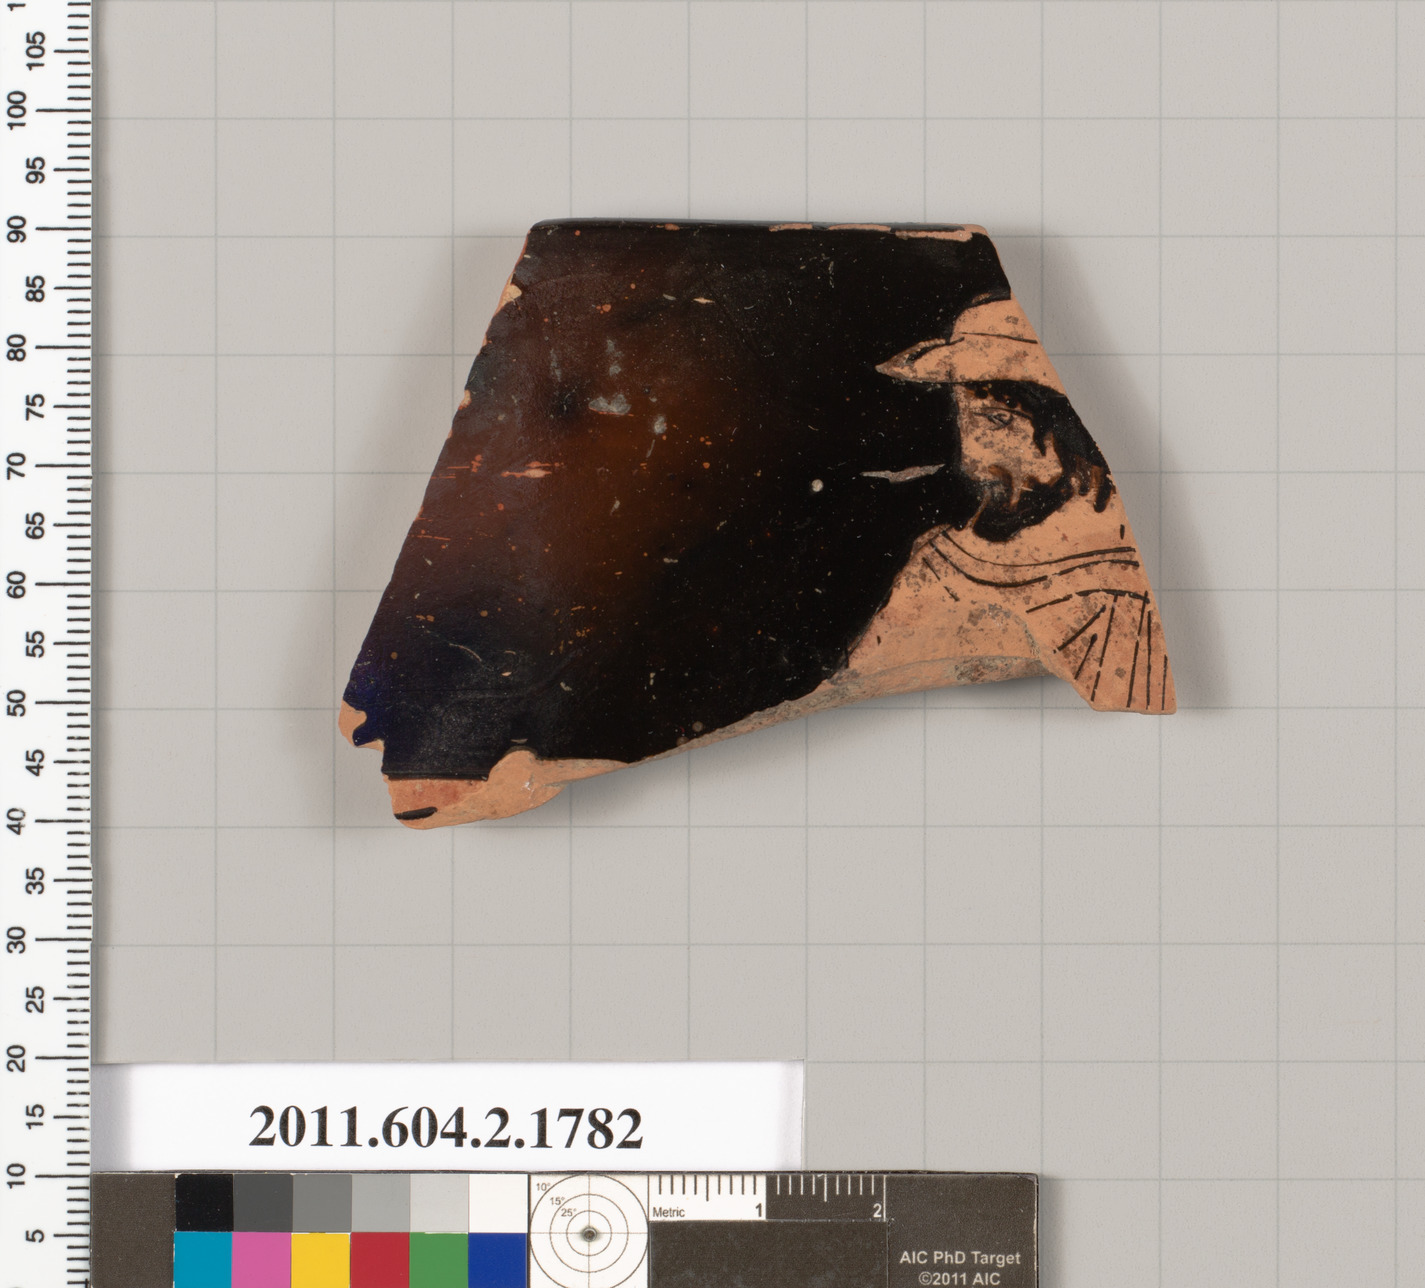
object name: skyphos fragment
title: Terracotta rim fragment of a skyphos (deep drinking cup)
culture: greek, attic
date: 450-426 BCE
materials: terracotta